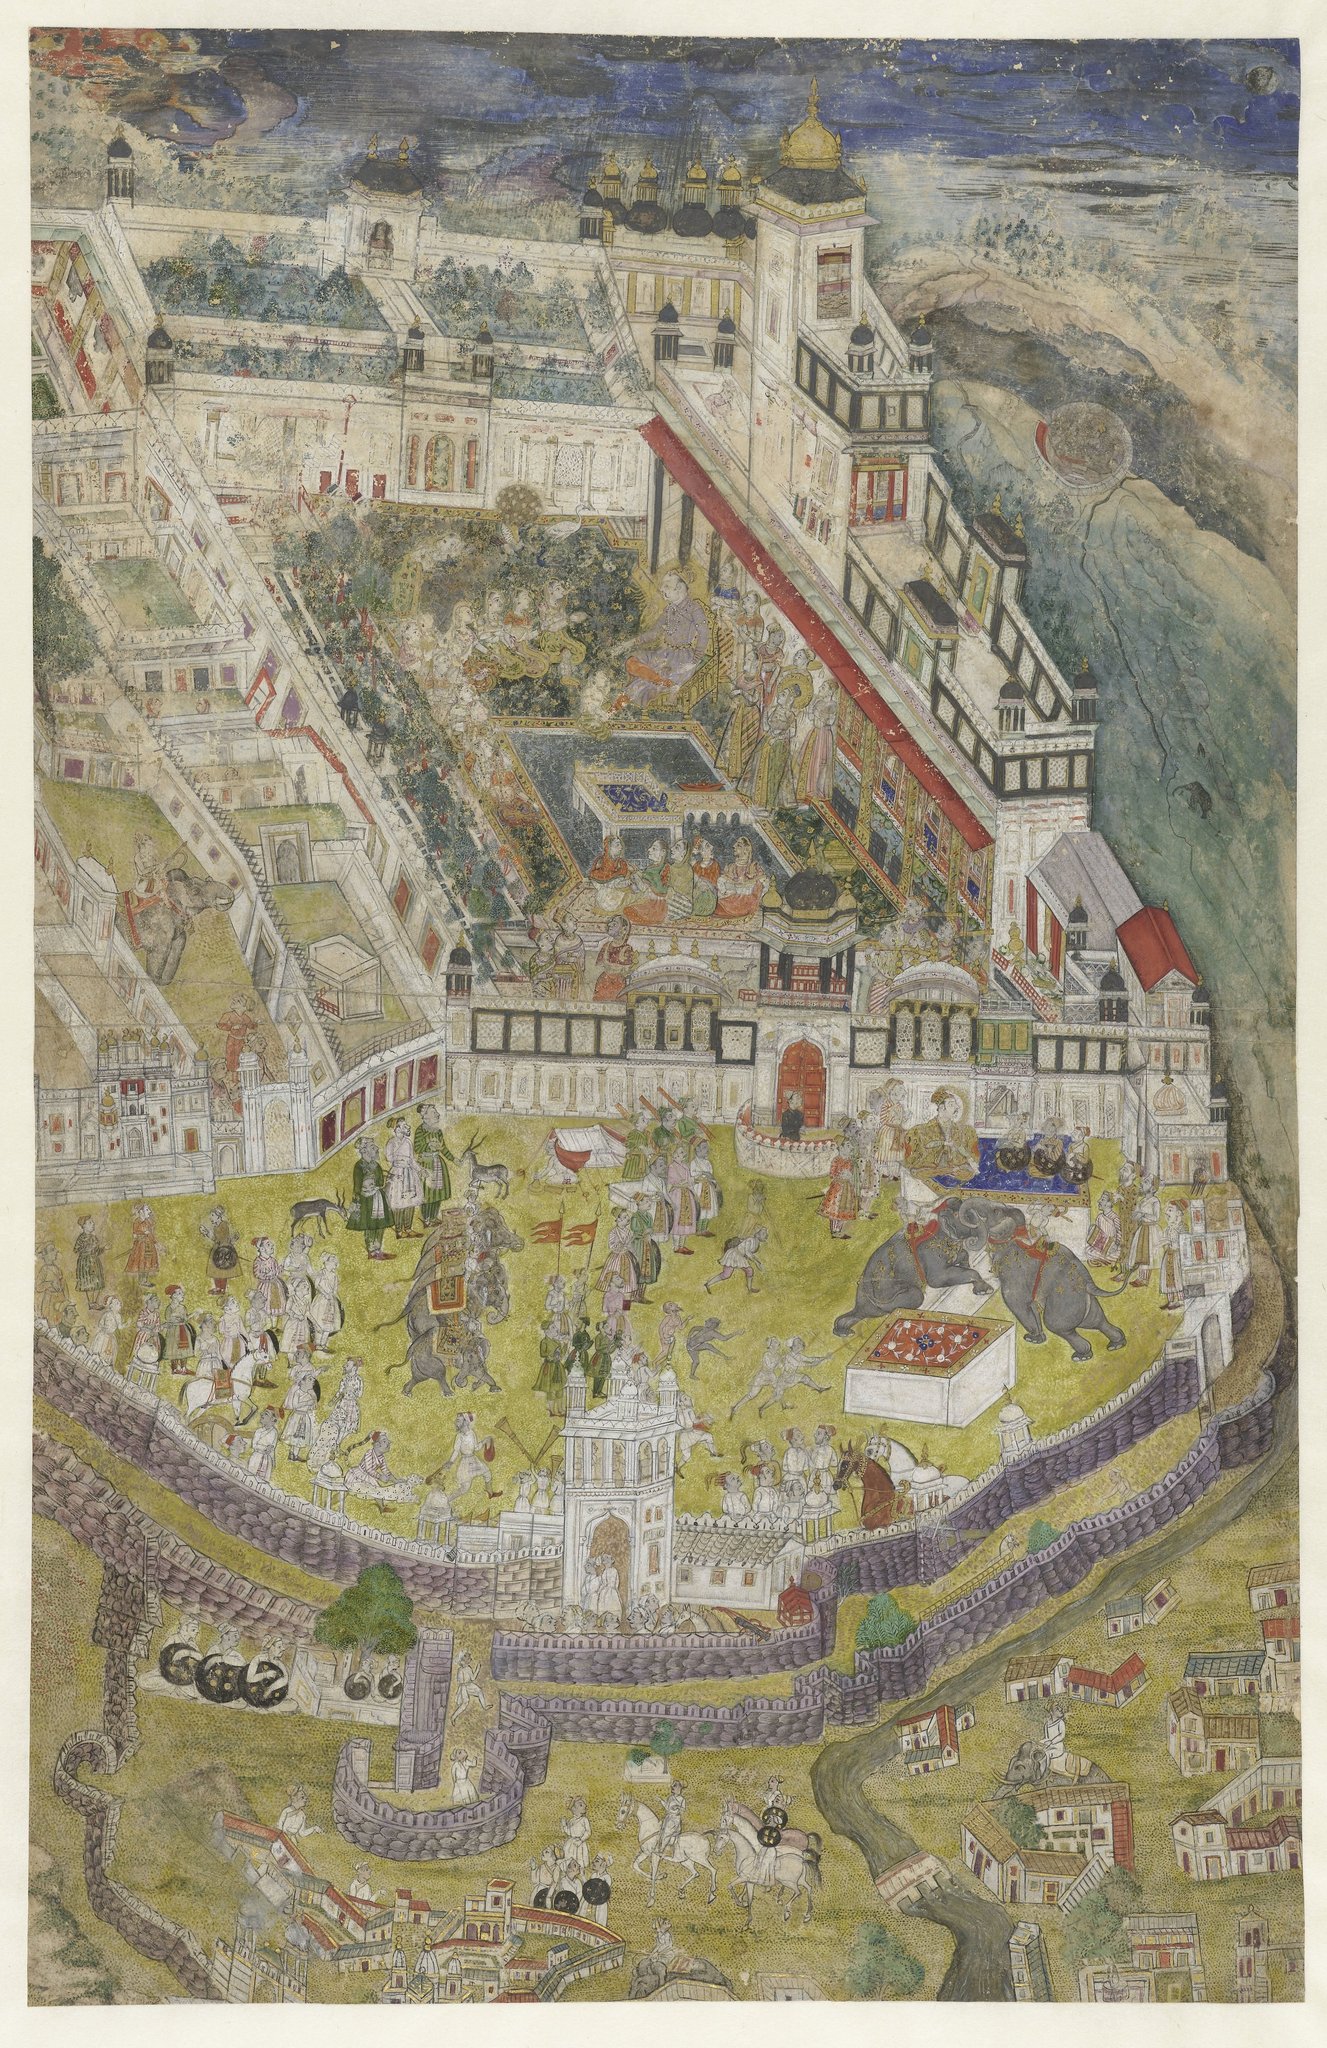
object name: indian miniature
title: Het paleis in Kotah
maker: Anonymous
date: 1700-1710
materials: gouache, paper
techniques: brush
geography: kotah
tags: kotah